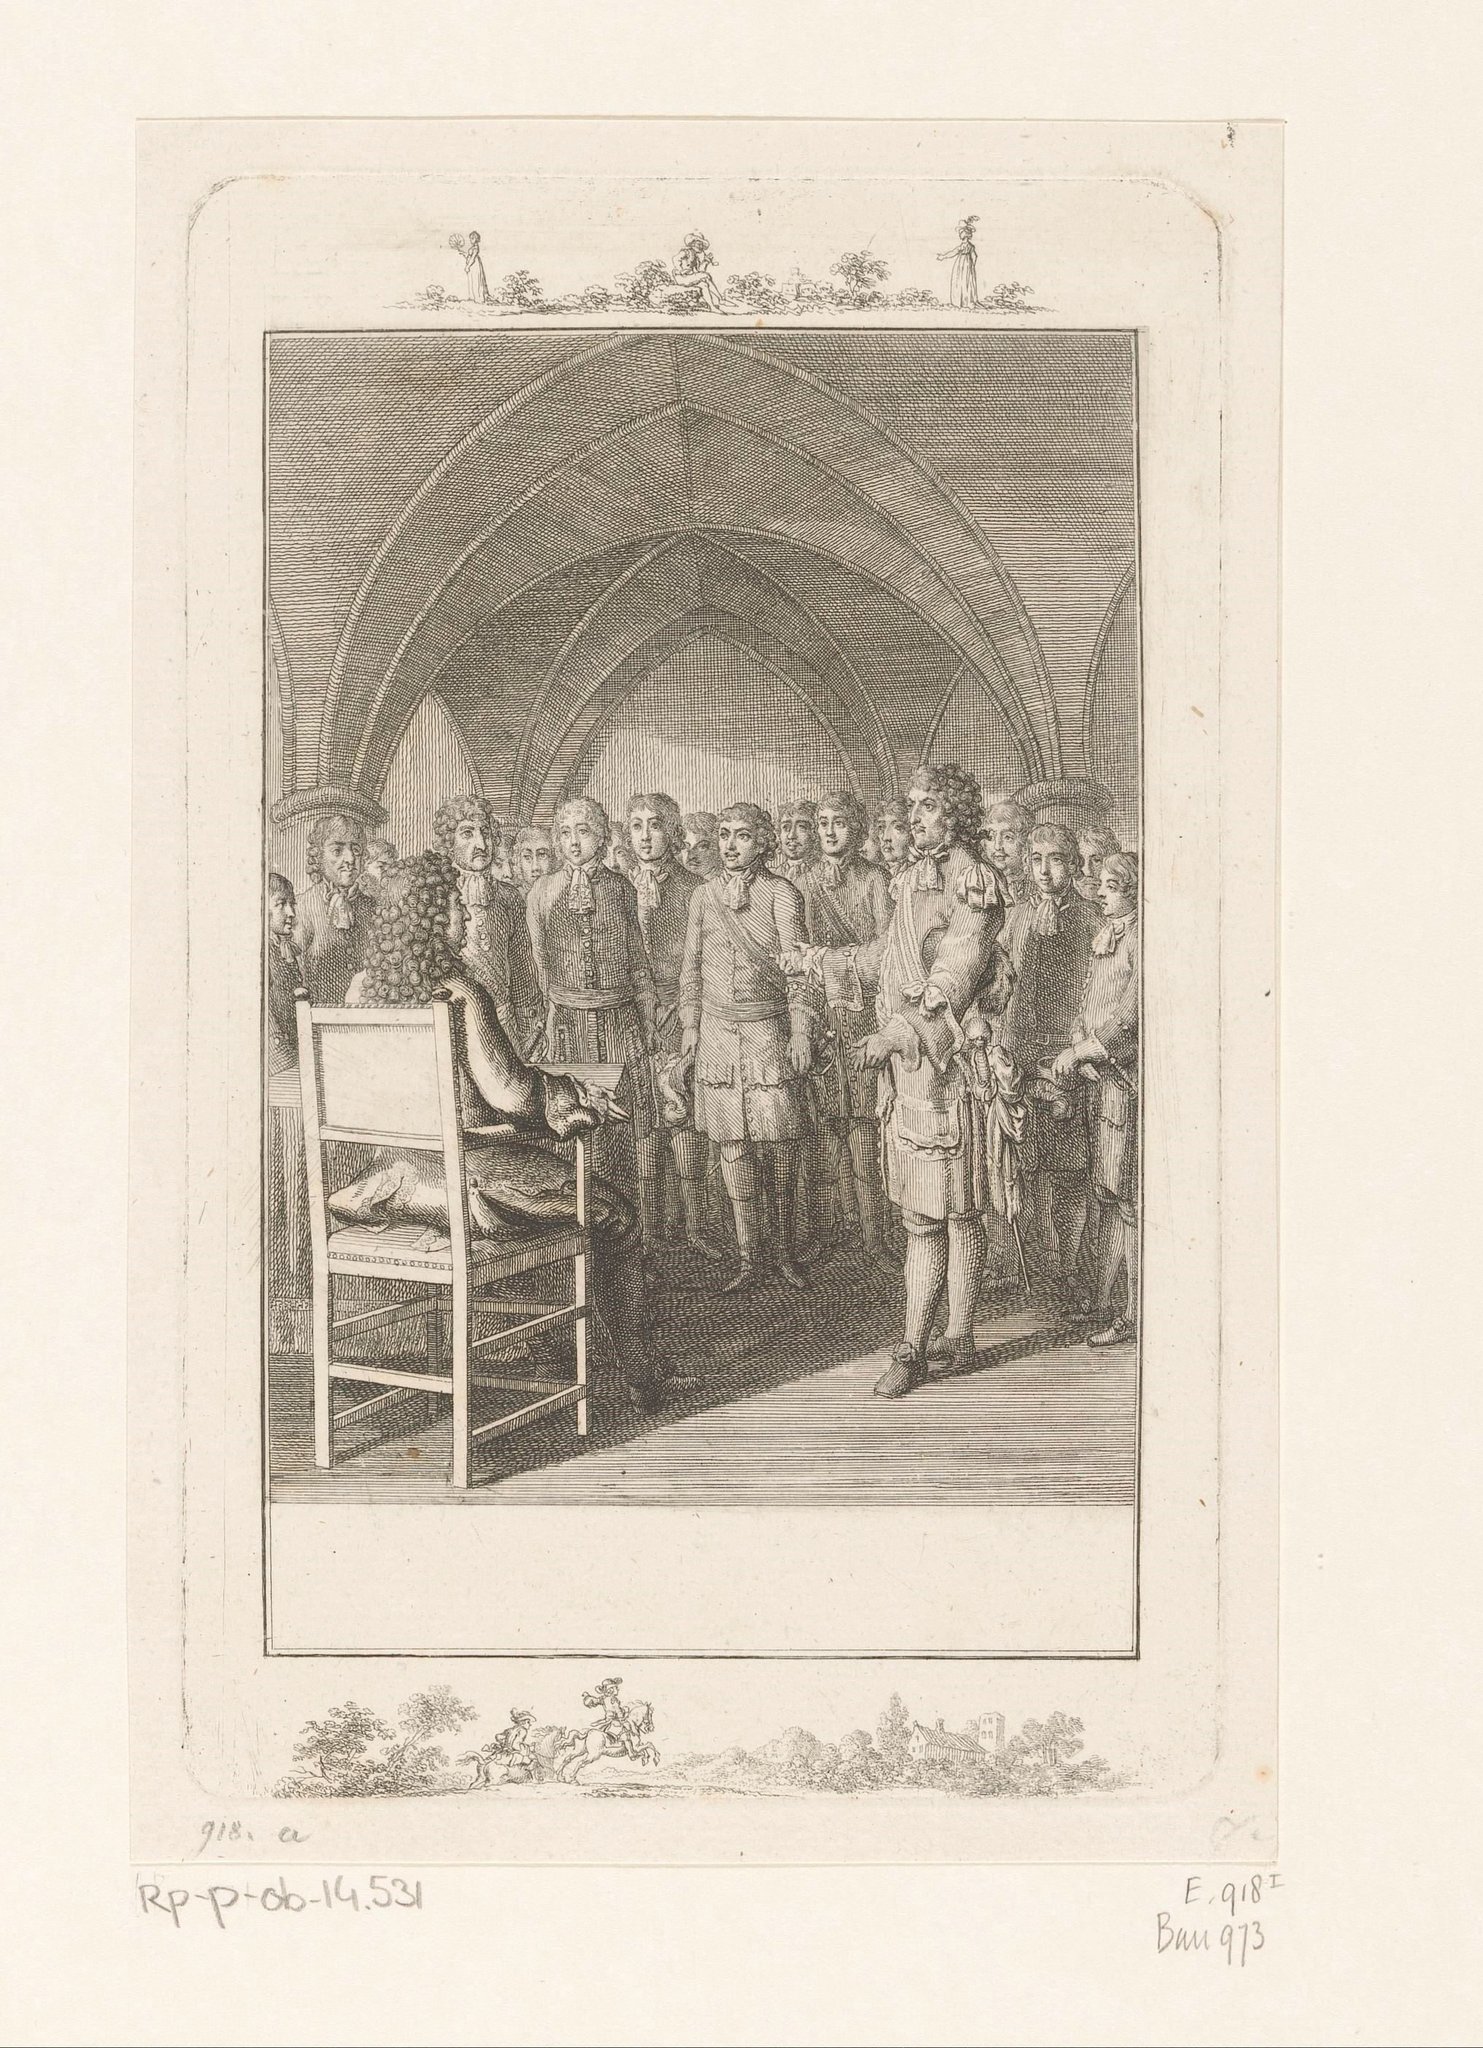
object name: print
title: Friedrich I wordt voorgesteld door de hertog van Schomberg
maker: daniel nikolaus chodowiecki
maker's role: draughtsman, print maker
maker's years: 1726-1801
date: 1799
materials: paper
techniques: etching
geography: berlin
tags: berlin, friedrich i (koning van pruisen), introducing, commander-in-chief, general, marshal, ruler, sovereign, vault ~ architecture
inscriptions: collector's mark: Lugt 2228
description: Prent gebruikt voor: Erman, Jean Pierre. Mémoires pour servir à l'histoire des réfugiés françois dans les états du roi. 9 dln. Berlijn: Fred. Barbiez, 1799, dl. 9.